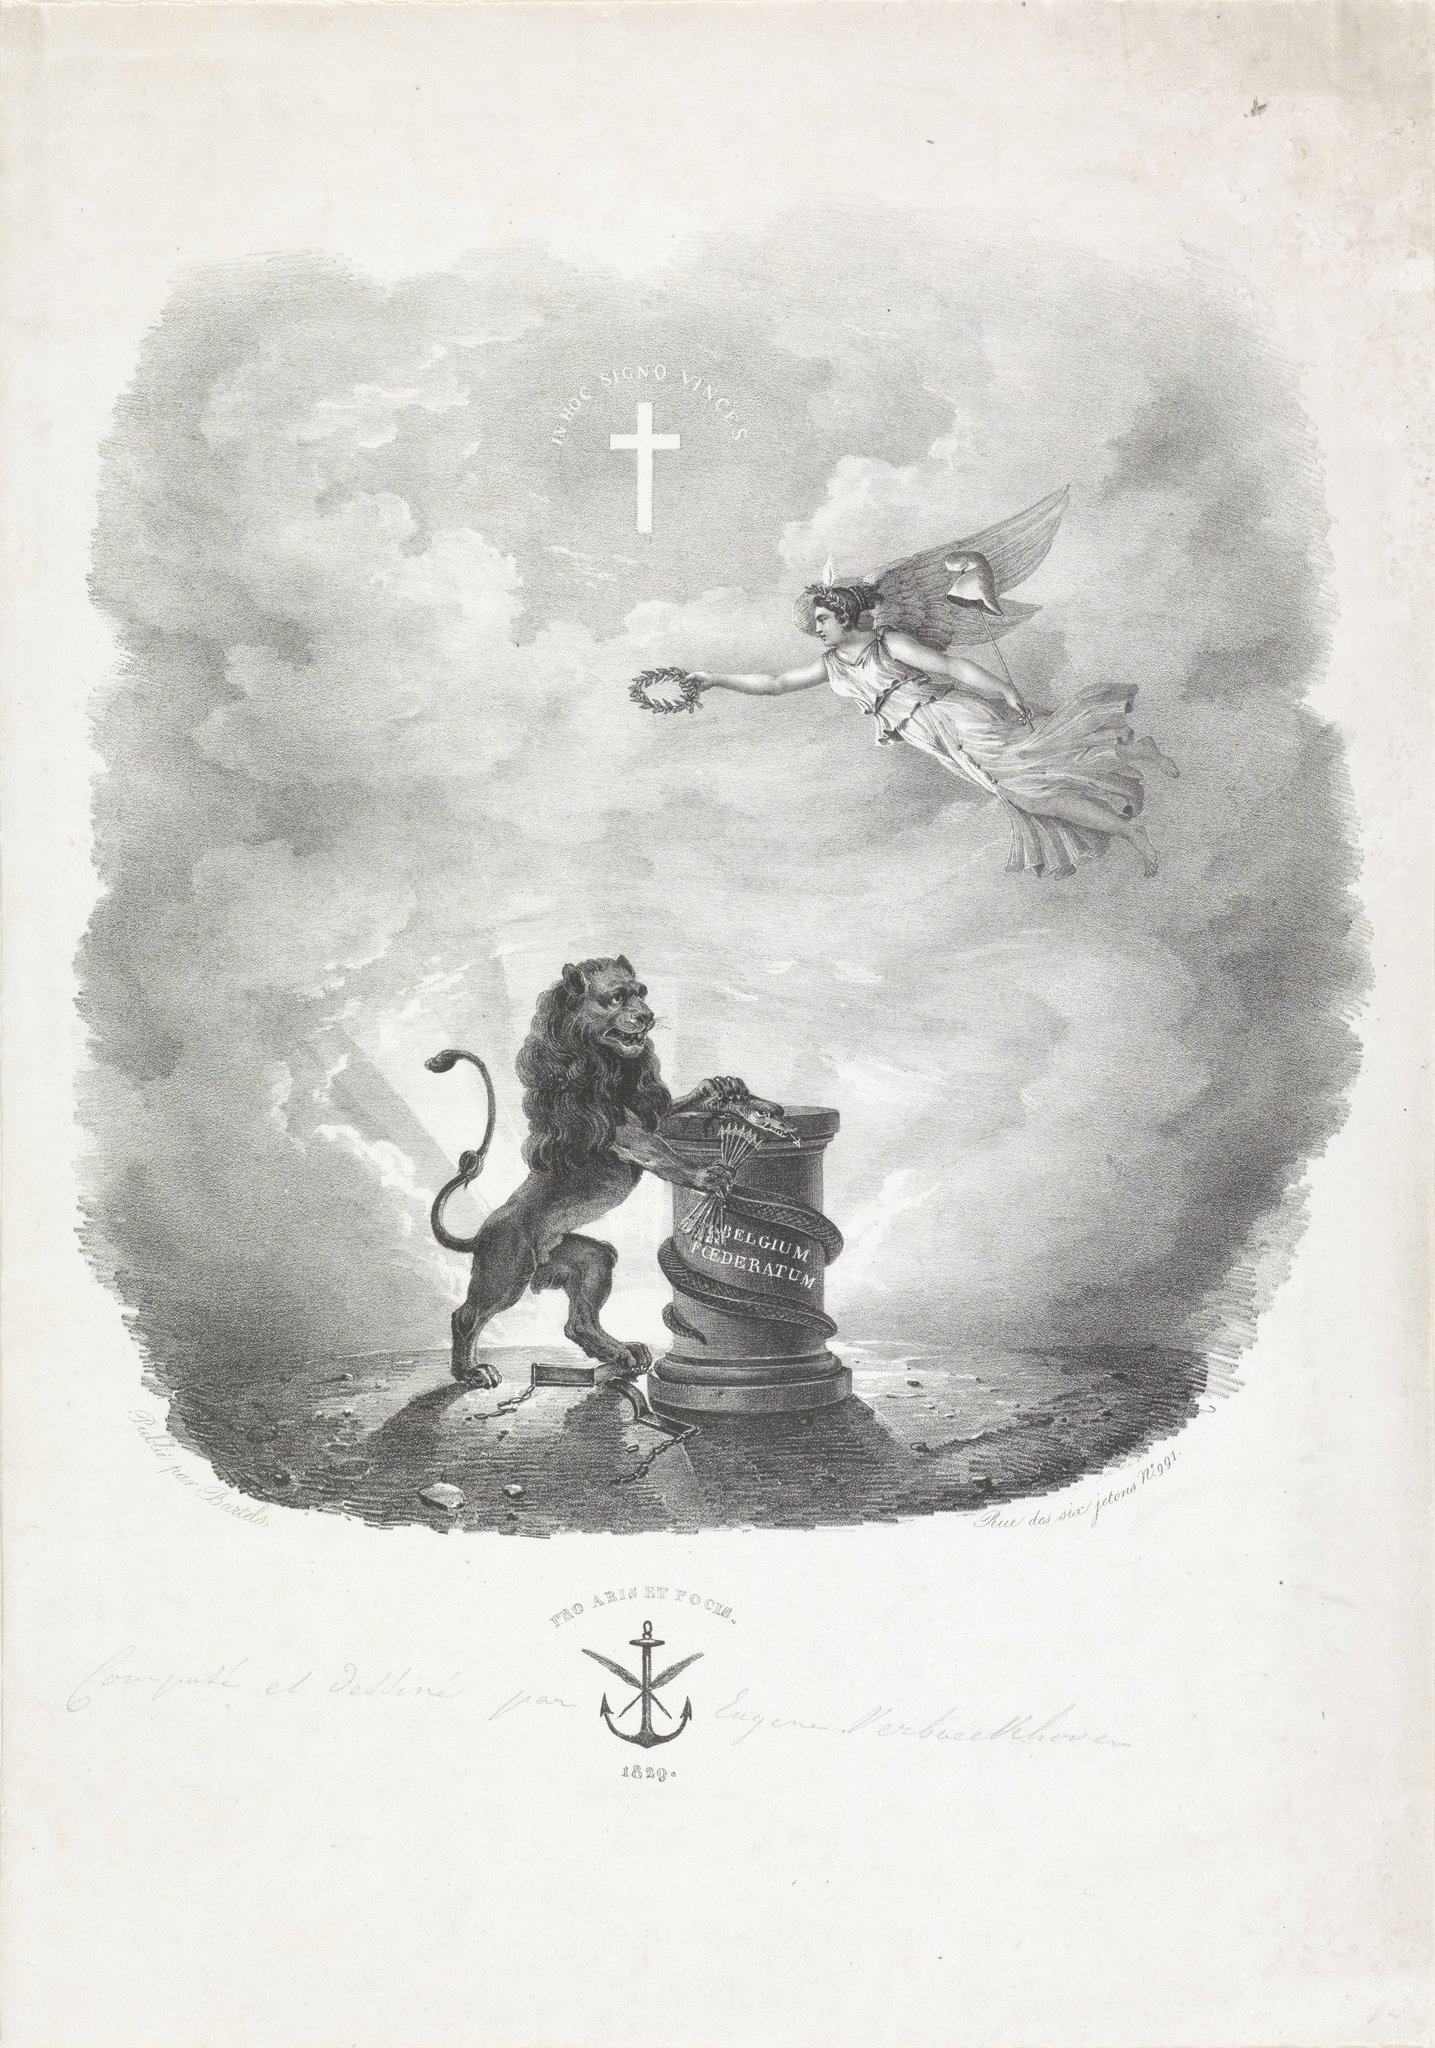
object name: print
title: Allegorie op de alliantie gesloten tussen de roomse klerikale partij en de liberale partij tegen de Nederlandse regering, 1829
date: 1829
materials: paper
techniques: lithograph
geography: southern netherlands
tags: freedom, liberty; 'libertà' (ripa) (+ abstract concept represented by female figure)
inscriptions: inscription: ‘Composé et dessiné par Eugene Verboeckhoven’, collector's mark: Lugt 2228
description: Allegorie op de alliantie gesloten tussen de roomse klerikale partij en de liberale partij in de Zuidelijke Nederlanden tegen de Nederlandse regering, 1829. De Belgische leeuw staande bij een altaar, hij vertreedt een gebroken boei en verdrukt met een poot een slang op het altaar. In de wolken reikt de Vrijheid de leeuw een lauwerkrans. In de hemel een kruis met opschrift 'In hoc signo vinces'. In het onderschrift een anker en twee gekruiste pennen en het opschrift 'Pro aris et focis'.